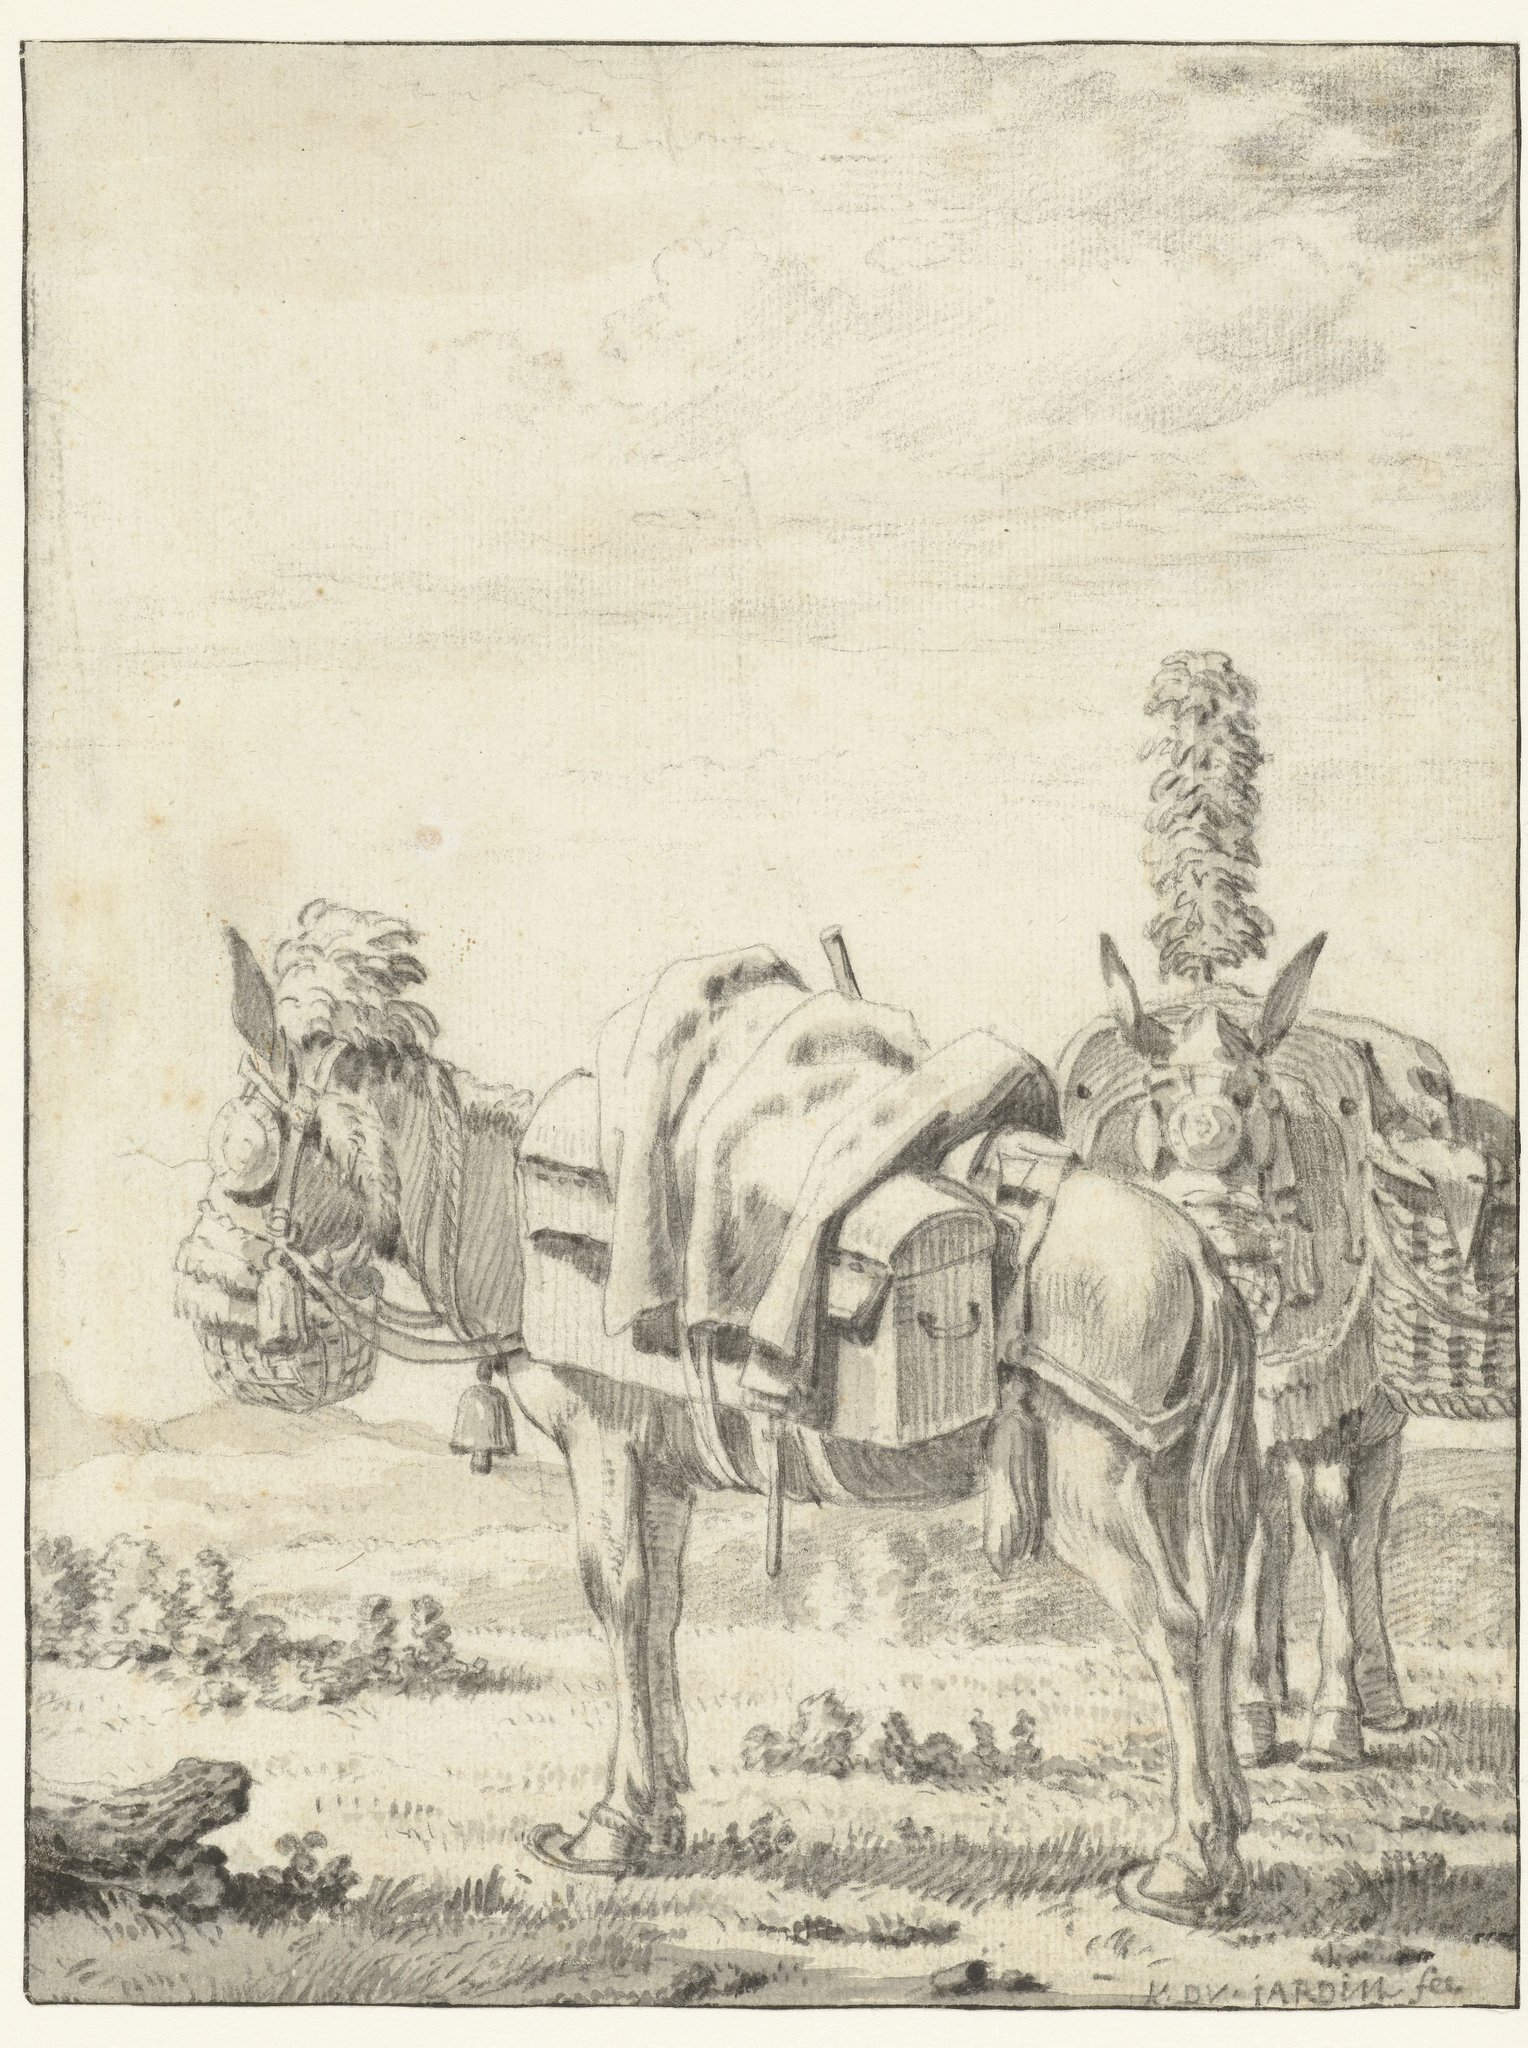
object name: drawing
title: Twee muilezels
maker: karel du jardin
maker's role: draughtsman, painter, print maker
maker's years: 1626-1678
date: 1632-1653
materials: chalk, paper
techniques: brush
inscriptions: signature: ‘K.DV.IARDIN.fe’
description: Ontwerp voor een ets in een serie uit 1652-1653.